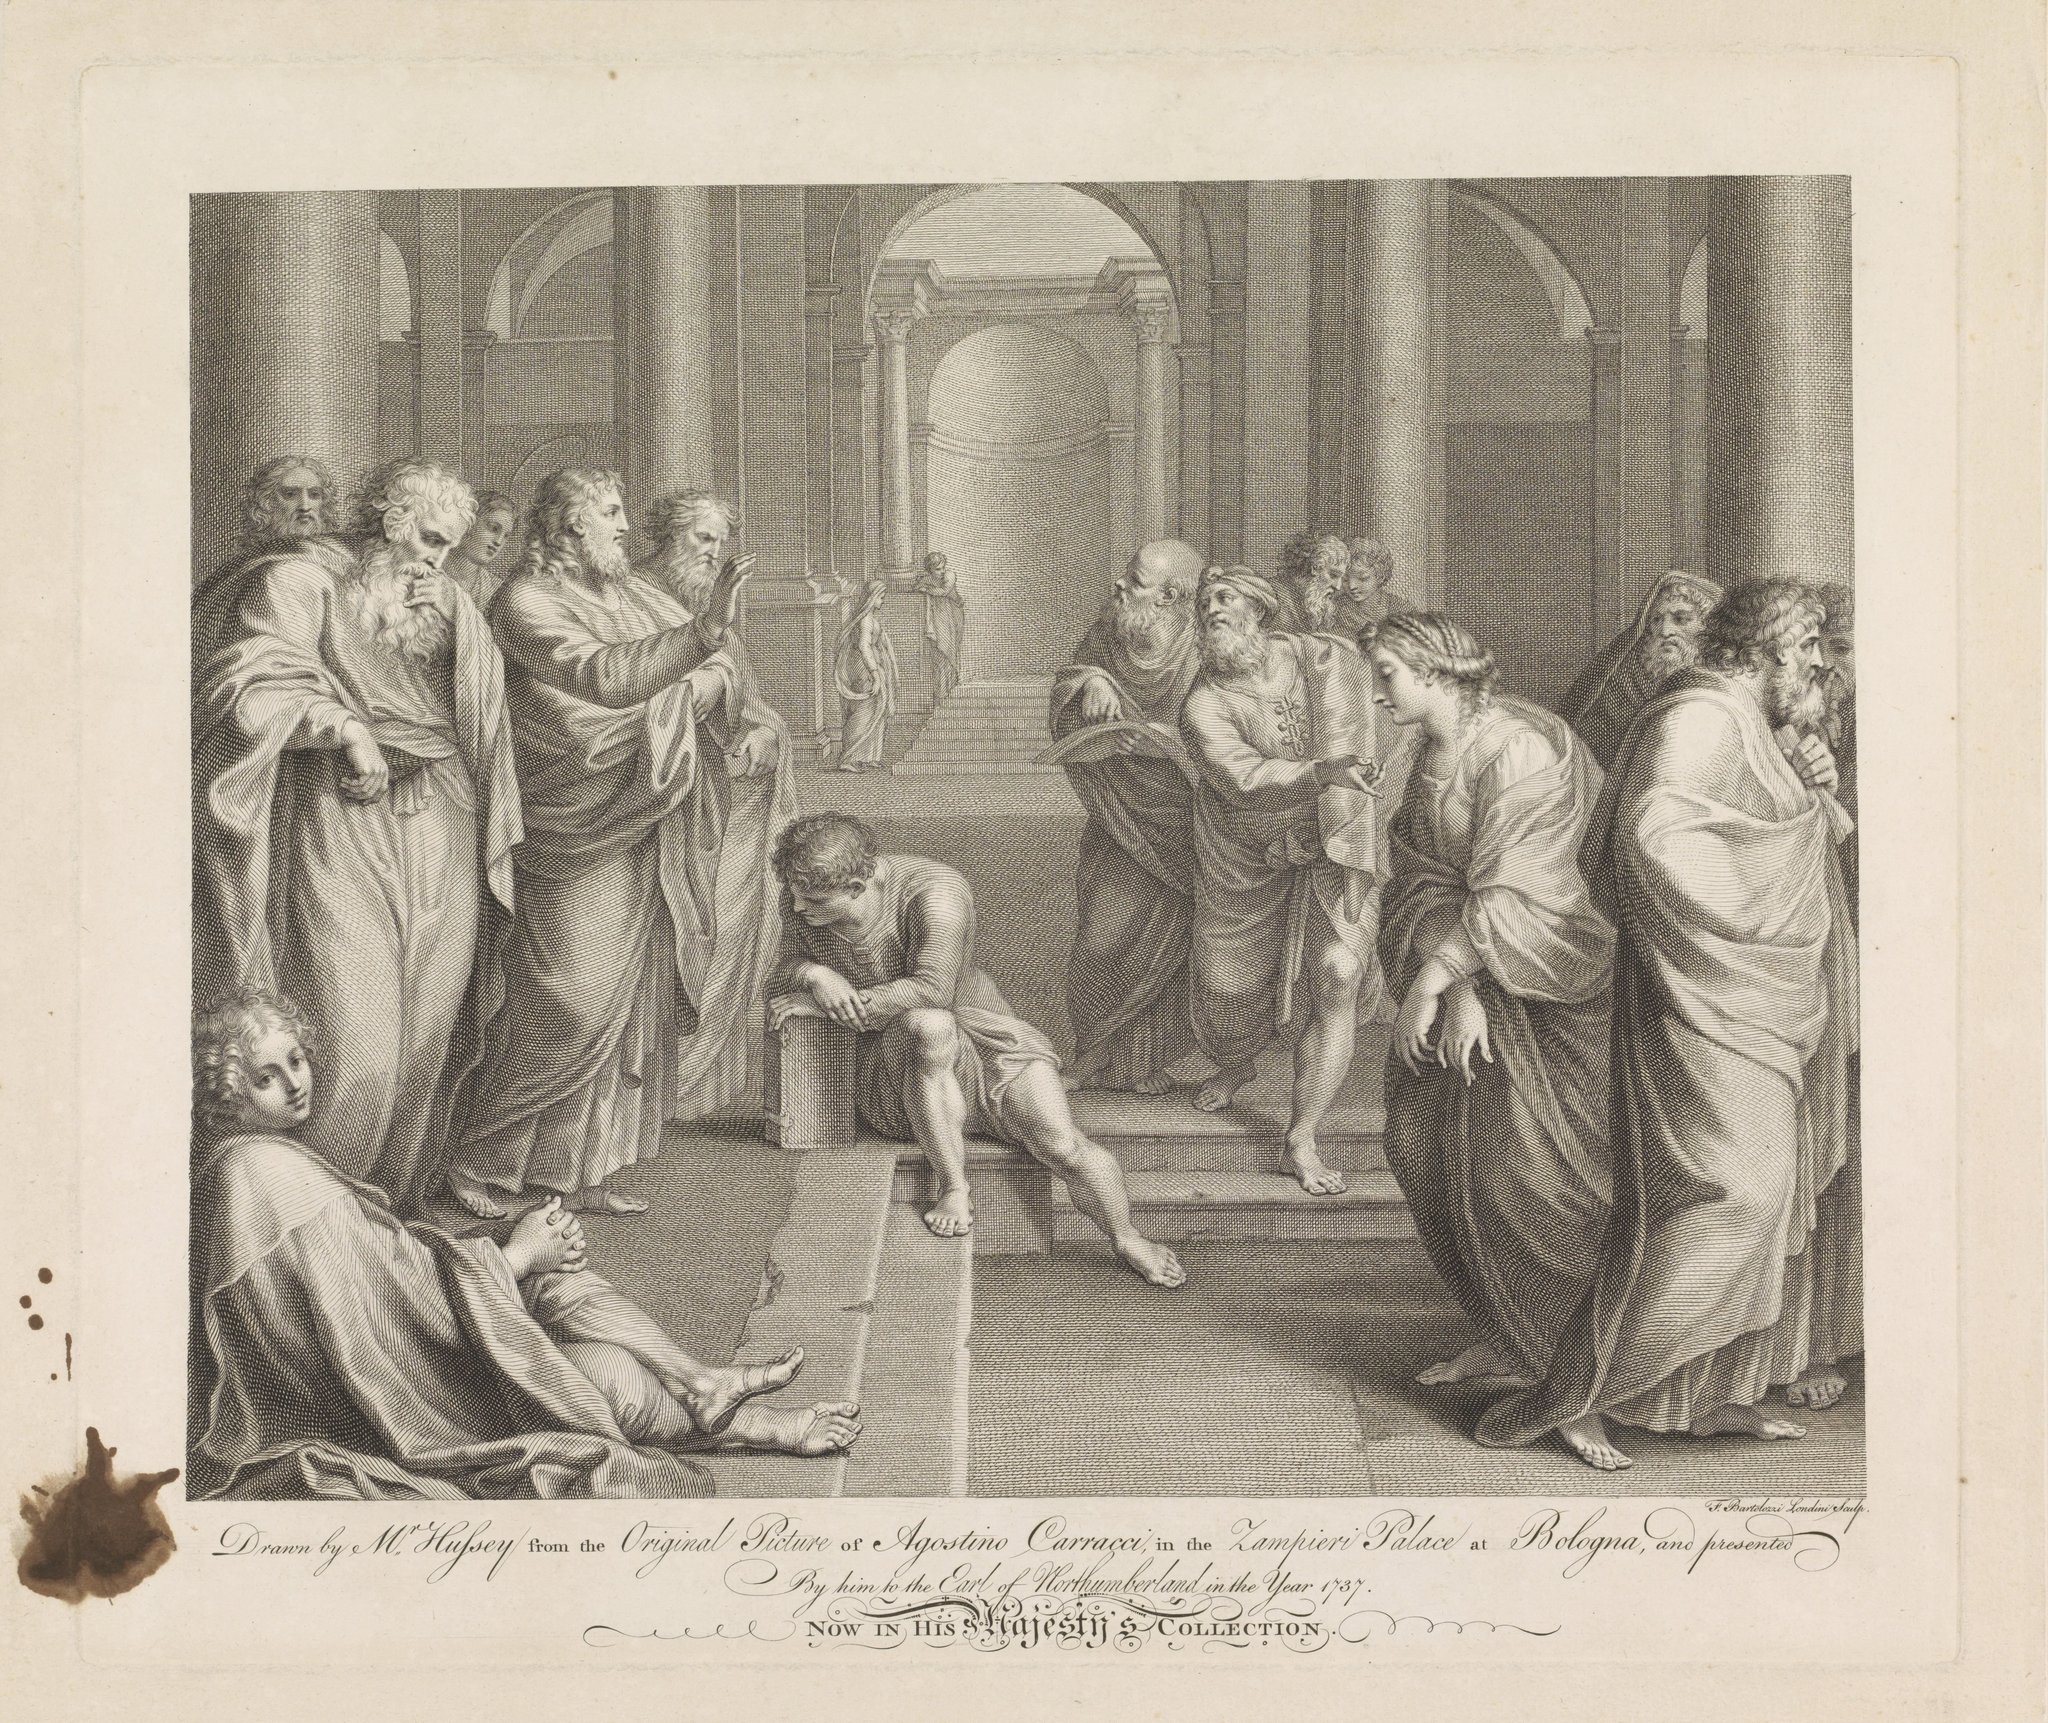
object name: print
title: Christus en de overspelige vrouw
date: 1738-1815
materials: paper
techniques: engraving, etching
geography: london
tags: pharisees bring a woman accused of adultery before christ (john 8:2-11)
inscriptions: collector's mark: Lugt 2228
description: Christus en de Farizeeën staan rond een overspelige vrouw in een tempel. Tekst in het Engels in ondermarge.